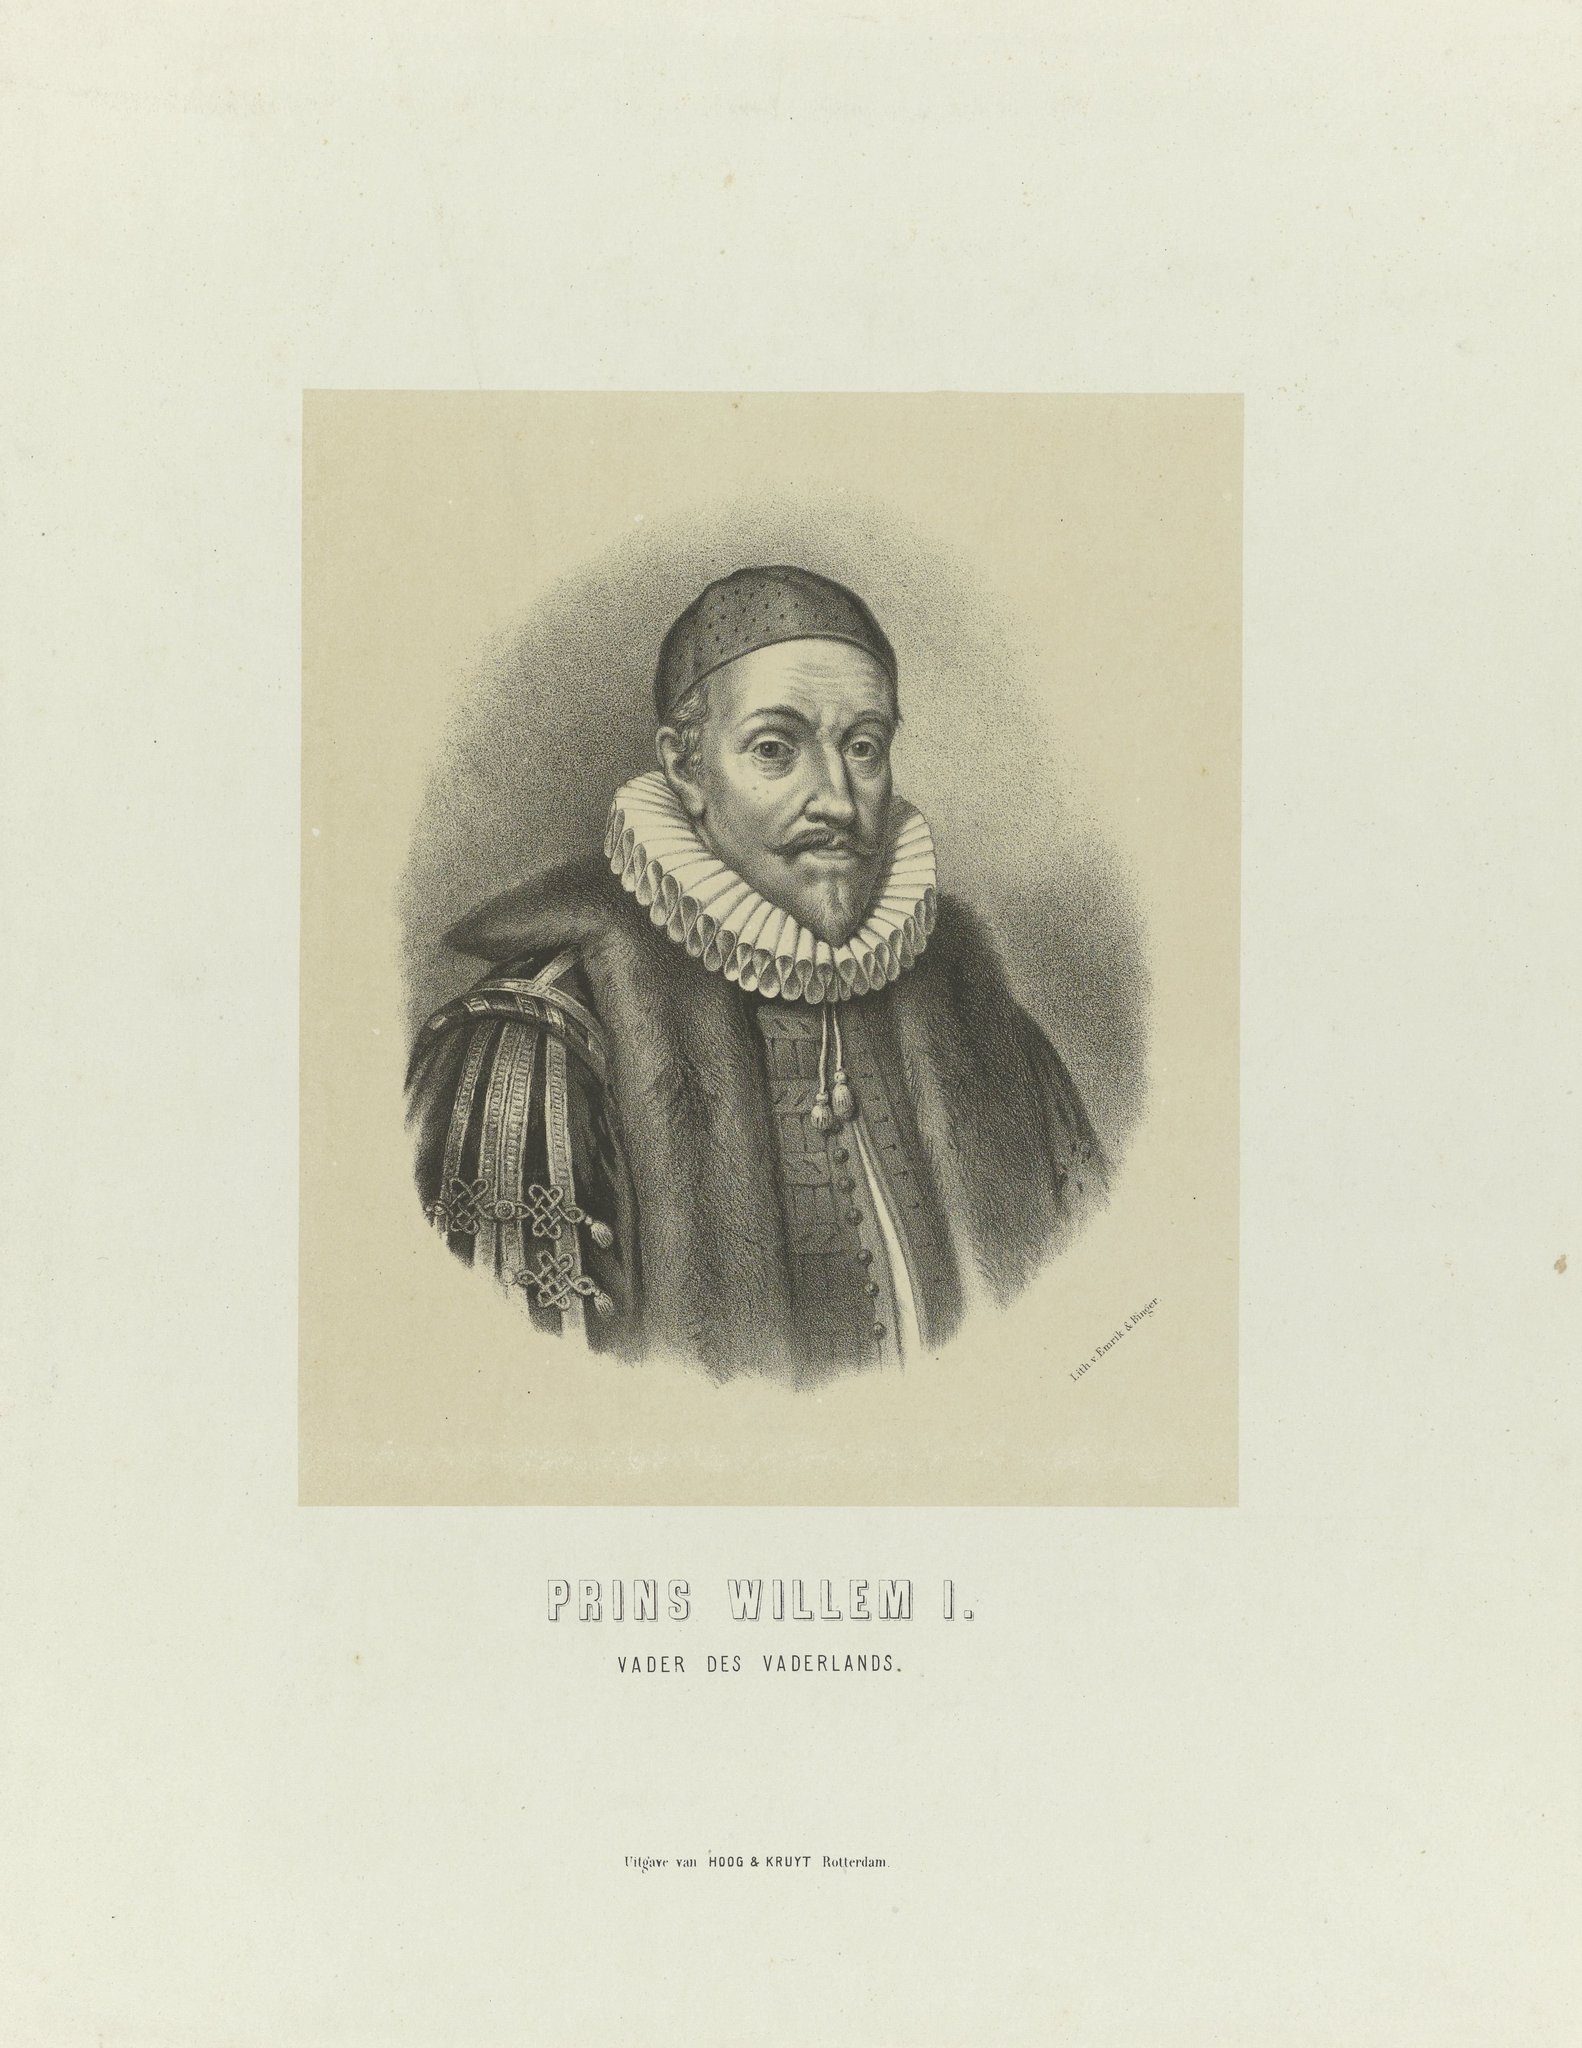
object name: print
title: Portret van Willem I, prins van Oranje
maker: Anonymous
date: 1856-1876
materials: paper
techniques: tone lithography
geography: rotterdam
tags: delft, william i (prince of orange)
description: De hier vermelde titel verwijst naar de hoogst verkregen titel van de geportretteerde, niet per se naar de titel die de geportretteerde op deze voorstelling draagt.